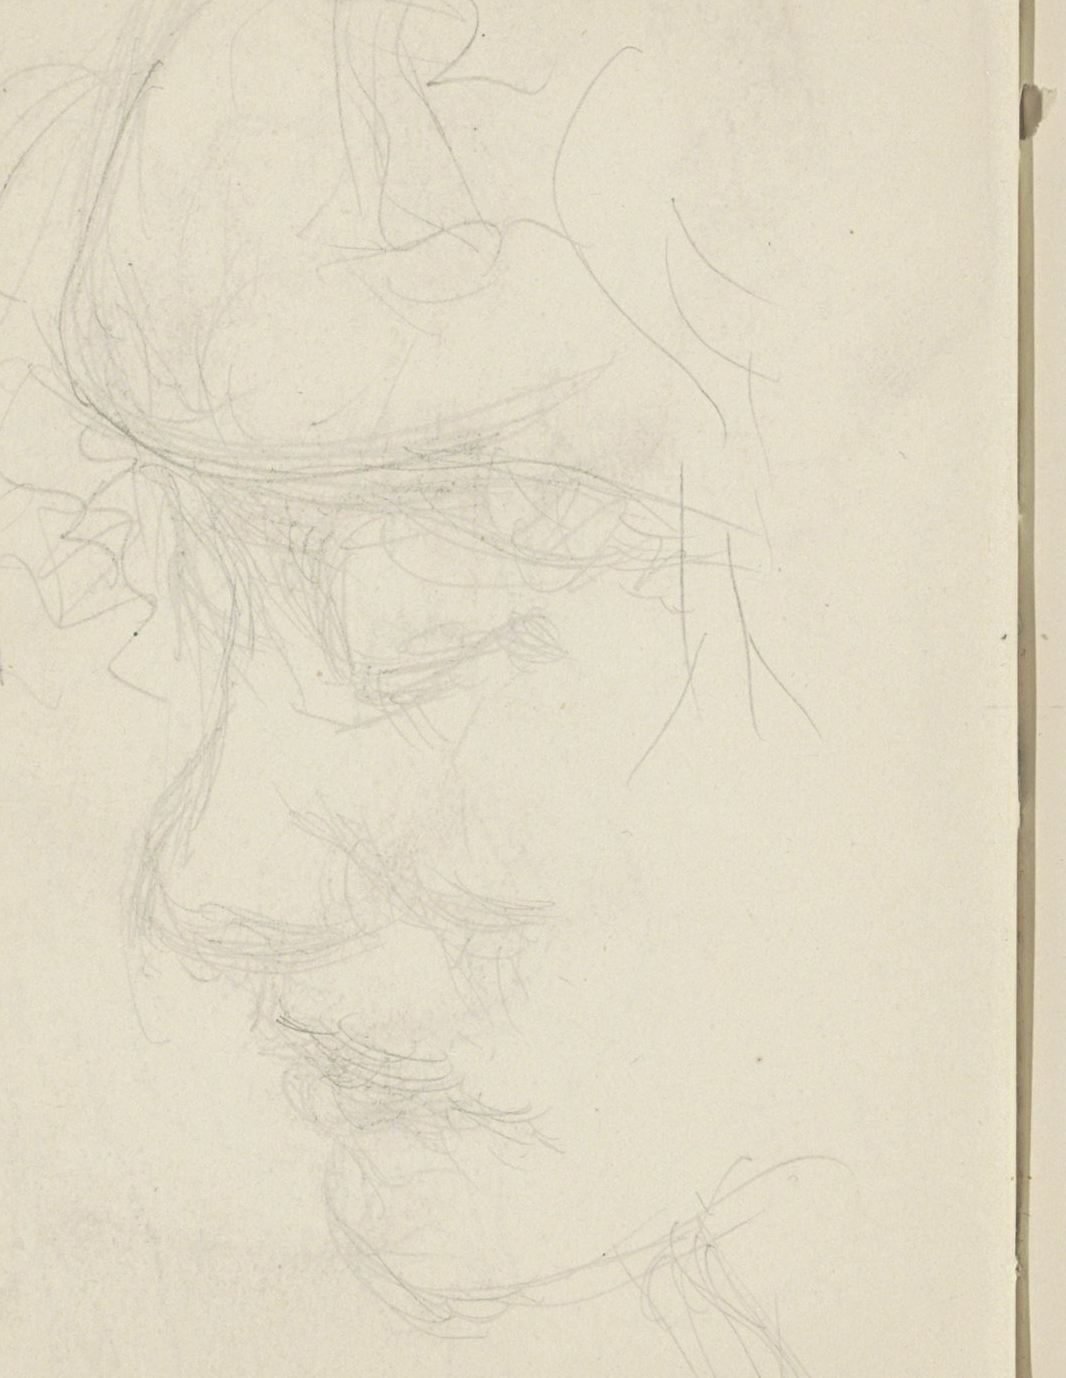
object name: sketchbook leaf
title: Gezicht van een vrouw met gesloten ogen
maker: reijer stolk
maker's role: draughtsman, print maker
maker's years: 1896-1945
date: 1906-1945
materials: paper, pencil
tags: face - aa - mask (mould taken from face), eyes closed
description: Blad 44 verso uit een schetsboek met 69 bladen.